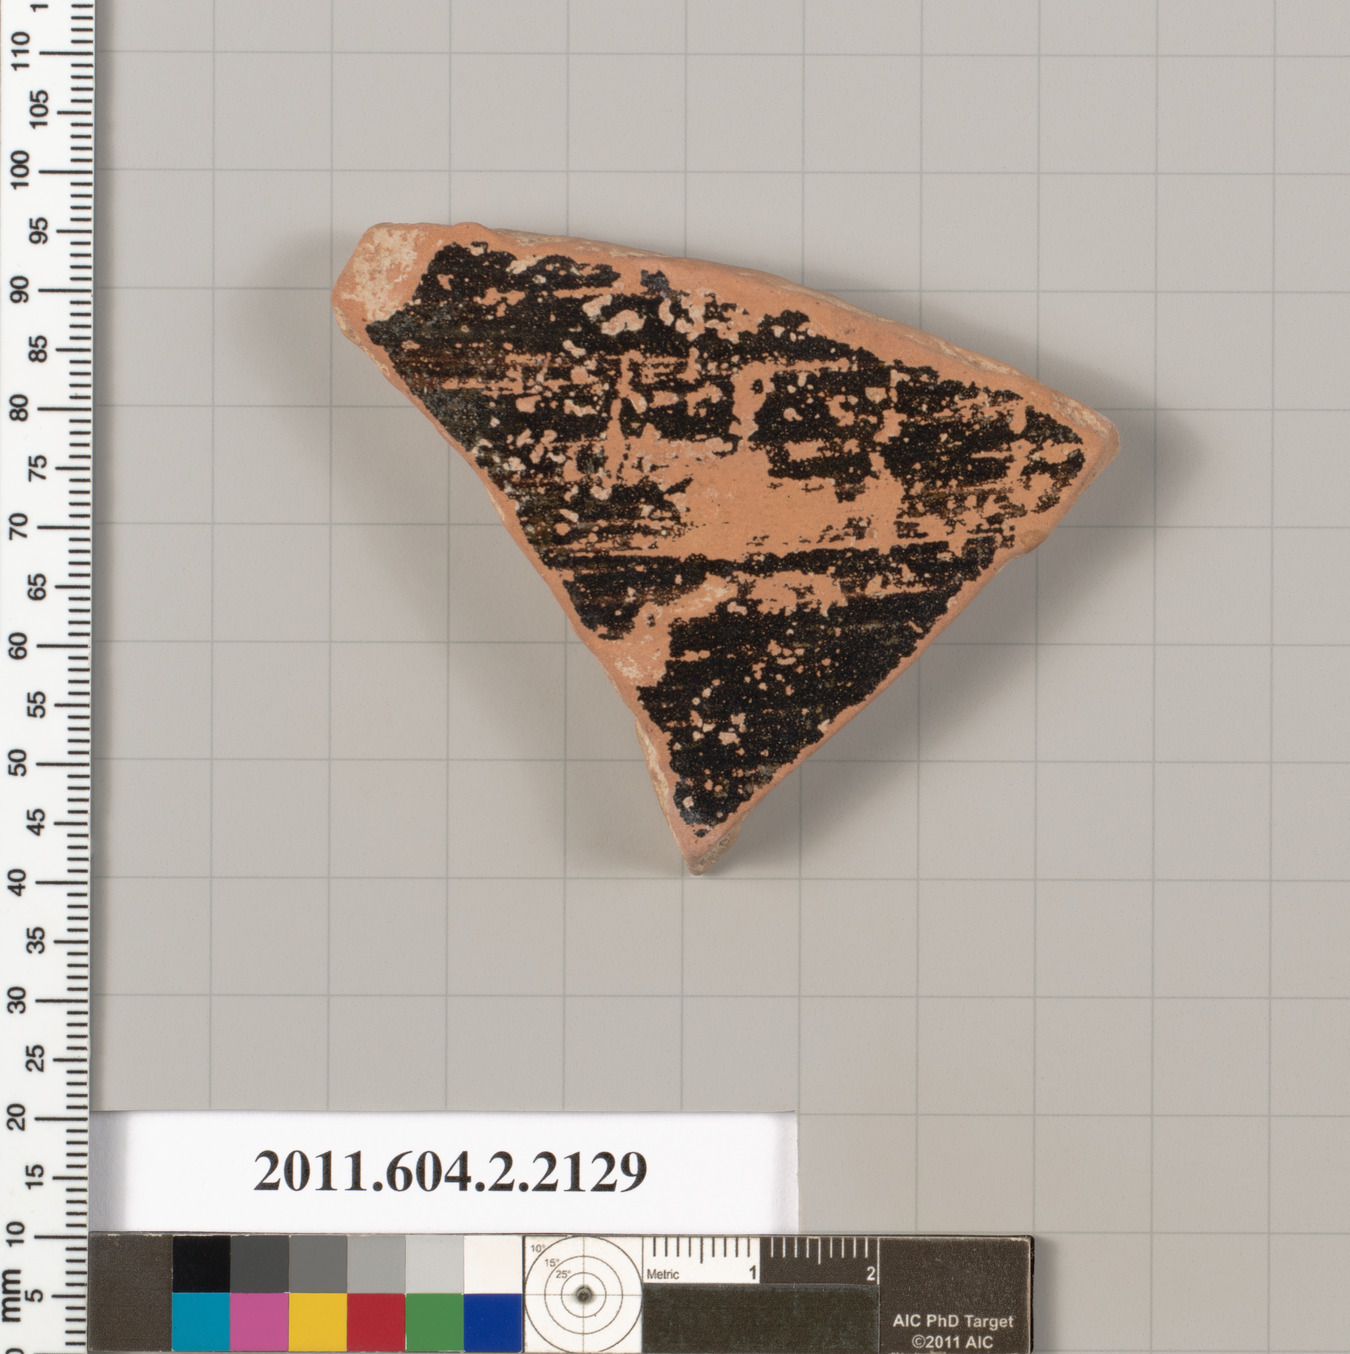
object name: amphora fragment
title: Terracotta fragment of an amphora (jar)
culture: greek, attic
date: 600-401 BCE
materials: terracotta